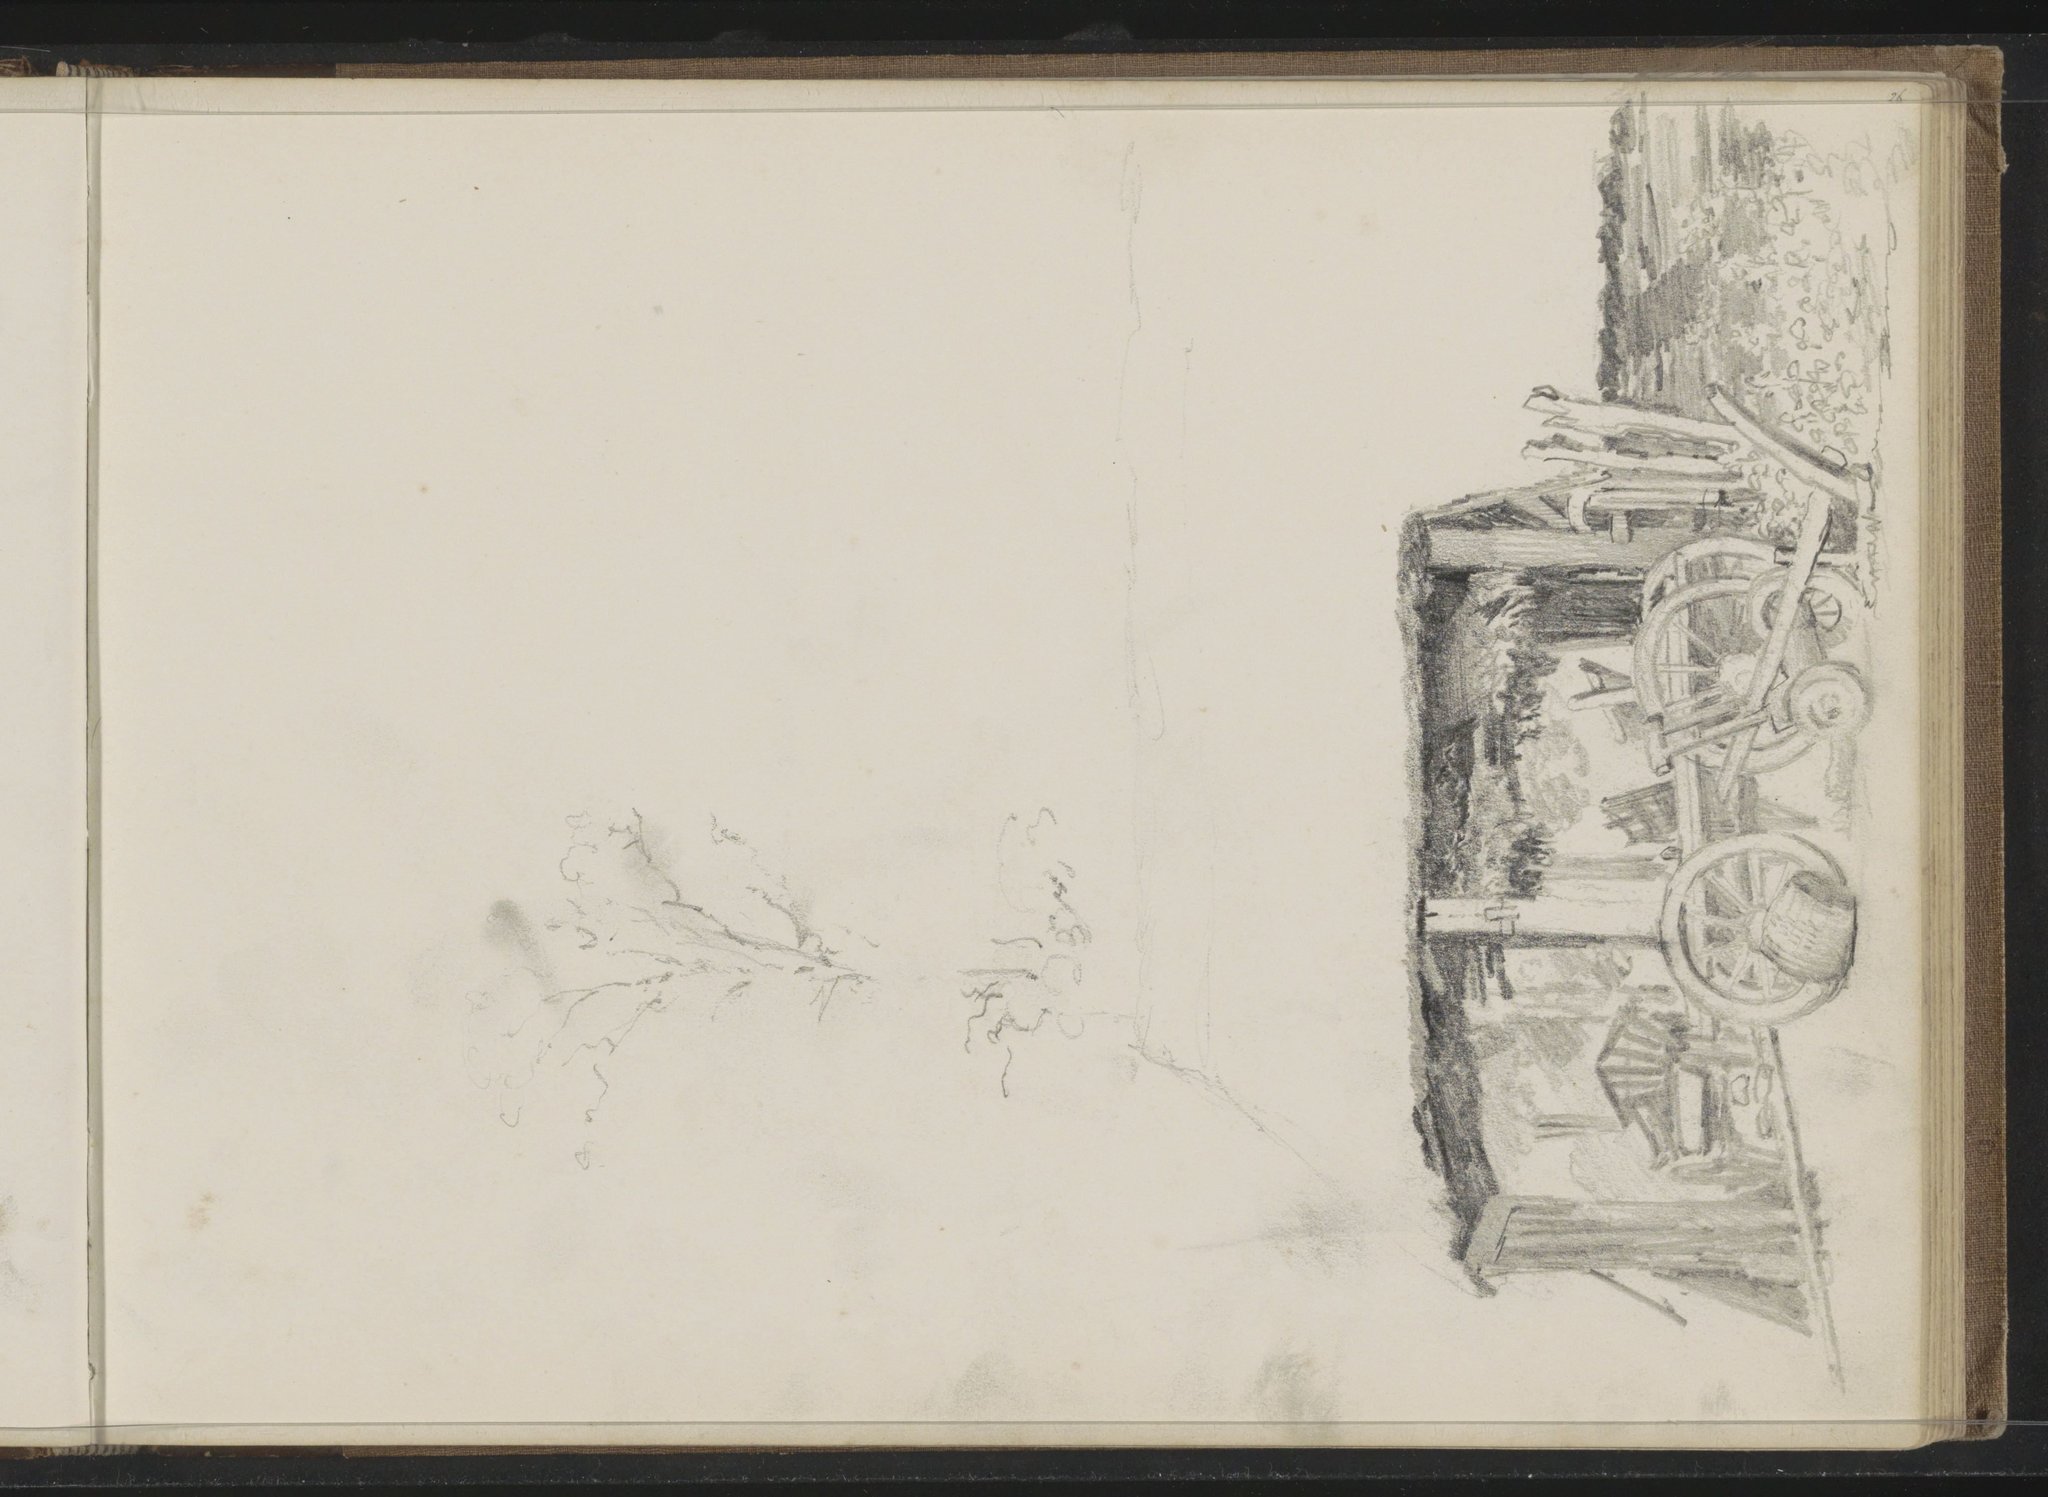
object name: sketchbook leaf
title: Ploeg voor een boerenschuur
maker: hendrik valkenburg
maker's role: draughtsman, painter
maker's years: 1826-1896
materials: paper, pencil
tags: cow, agricultural implements: plough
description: Blad 26 recto uit een schetsboek met 77 bladen.